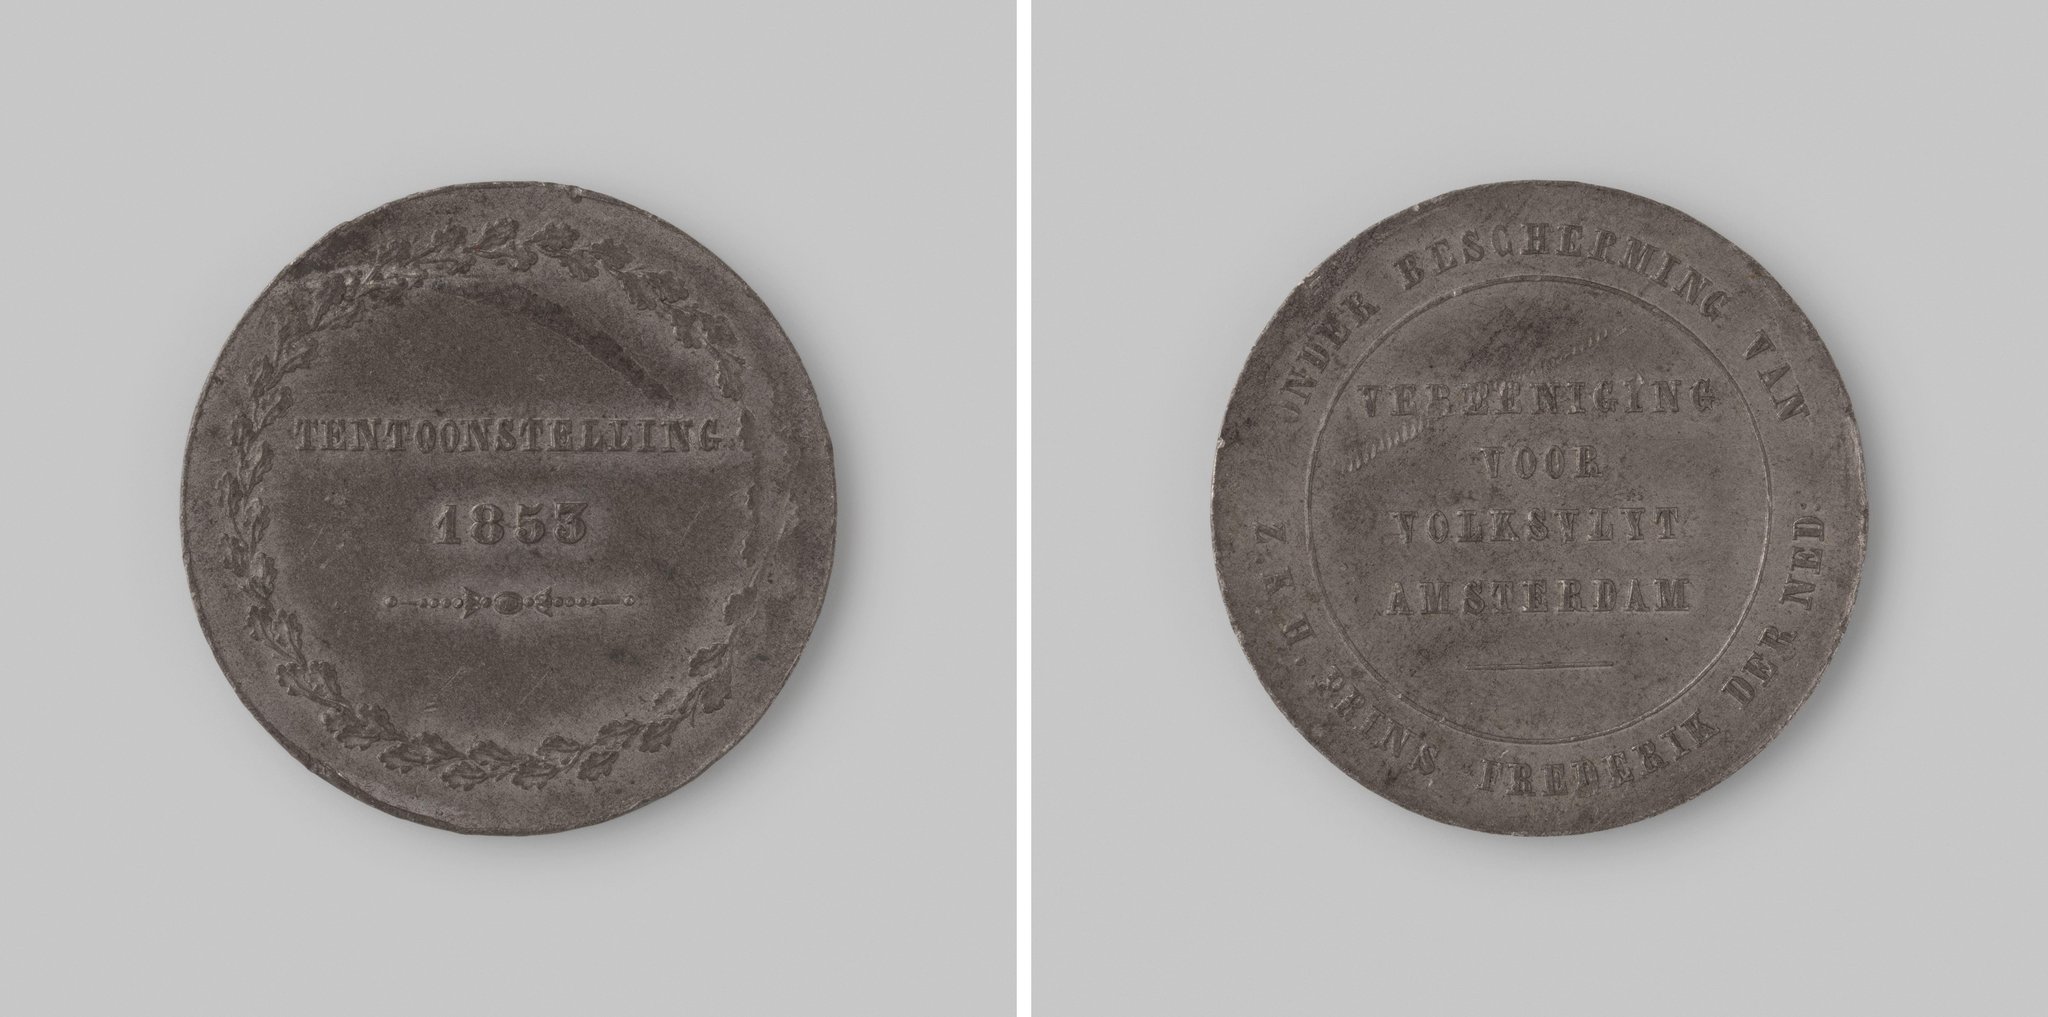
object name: history medal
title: Tentoonstelling van bouwmaterialen te Amsterdam door de Vereeniging van Volksvlijt 1853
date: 1853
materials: tin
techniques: striking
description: Tinnen penning, op de voorzijde twee regels tekst binnen een eikenkrans, op de voorzijde vier regels tekst met omschrift.